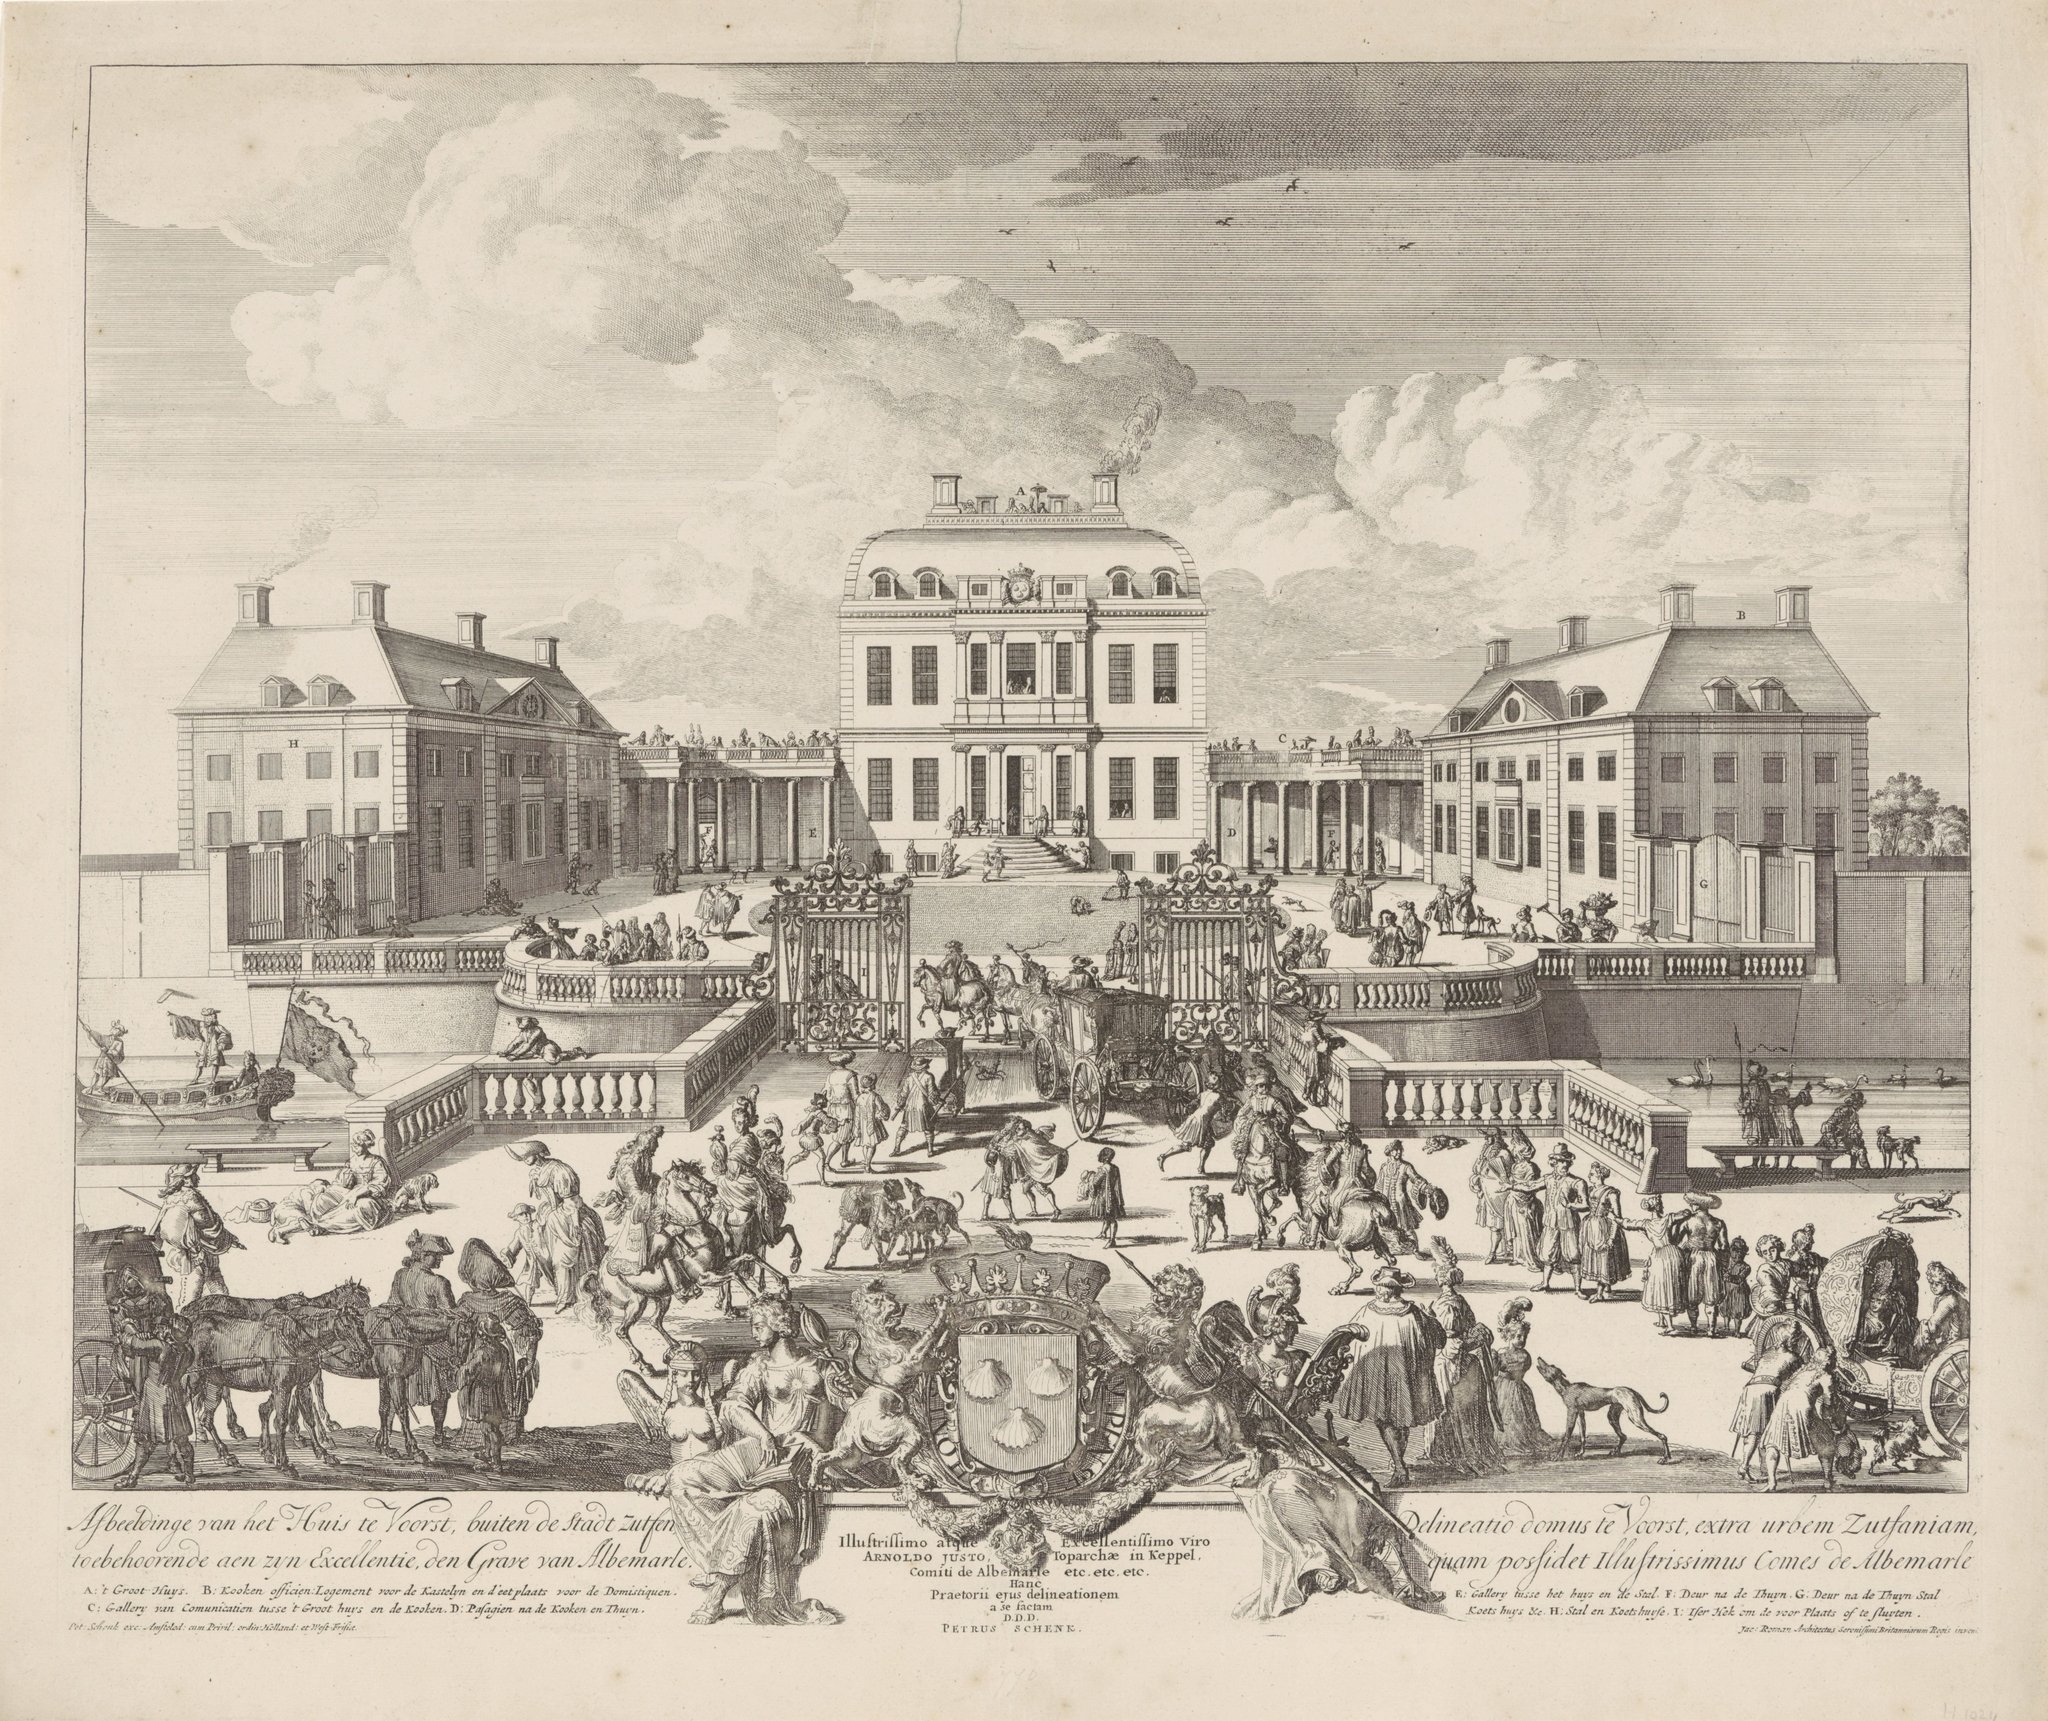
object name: print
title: Afbeeldinge van het Huis te Voorst, buiten de Stadt Zutfen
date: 1675-1711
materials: paper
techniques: etching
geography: amsterdam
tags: riding a horse, ass, or mule; rider, horseman, four-wheeled, animal-drawn vehicle, e.g.: cab, carriage, coach, dog, country-house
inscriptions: collector's mark: Lugt 2228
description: Gezicht op Huis de Voorst, met op de voorgrond mensen, koetsen, ruiters en honden. Het landhuis ligt onder Eefde in de Nederlandse gemeente Lochem.